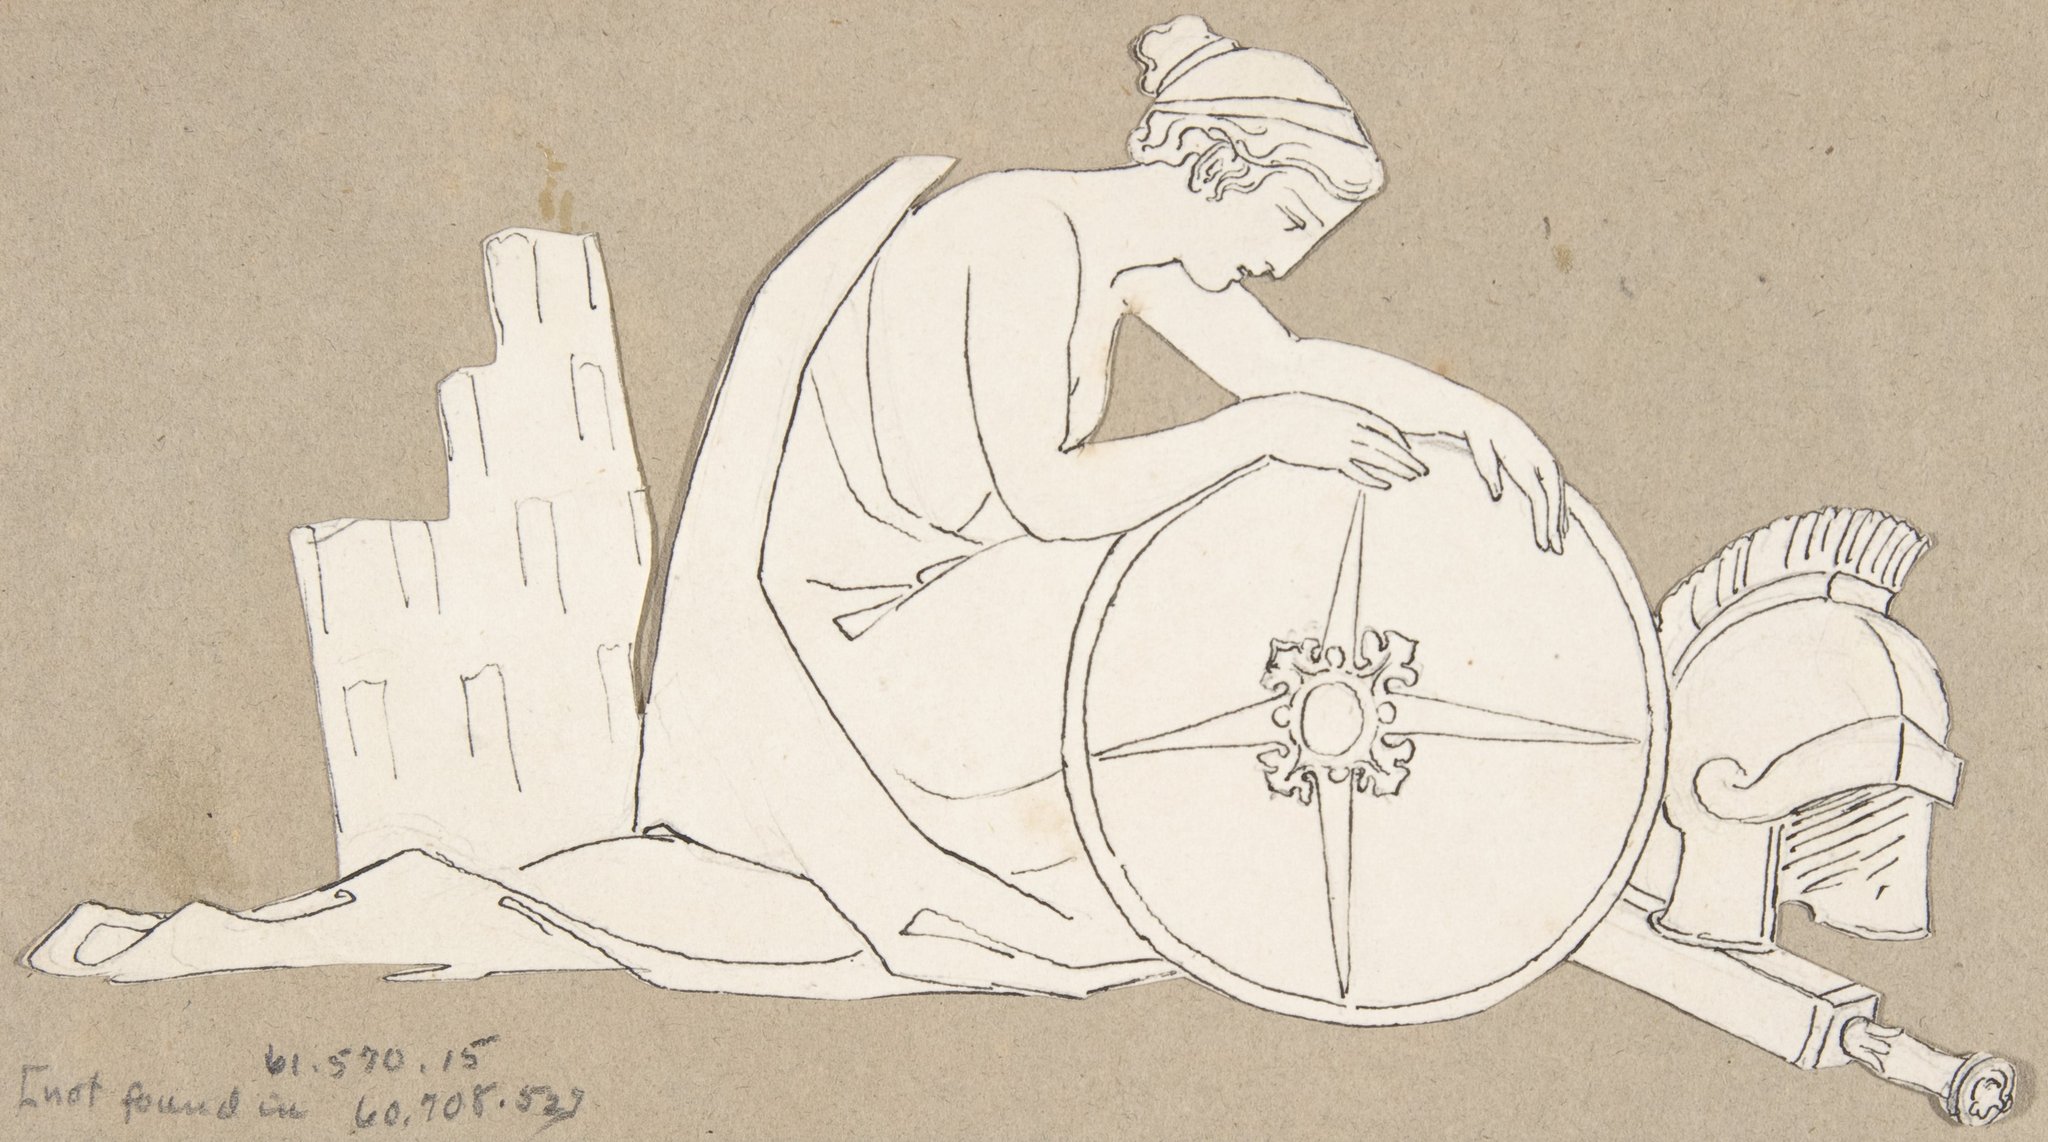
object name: drawing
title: Design for large fireplace white tiles produced in Wedgwood's factory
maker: john flaxman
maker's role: artist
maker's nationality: british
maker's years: 1755-1826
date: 1899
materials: graphite, ink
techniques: pen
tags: helmets,shields,women